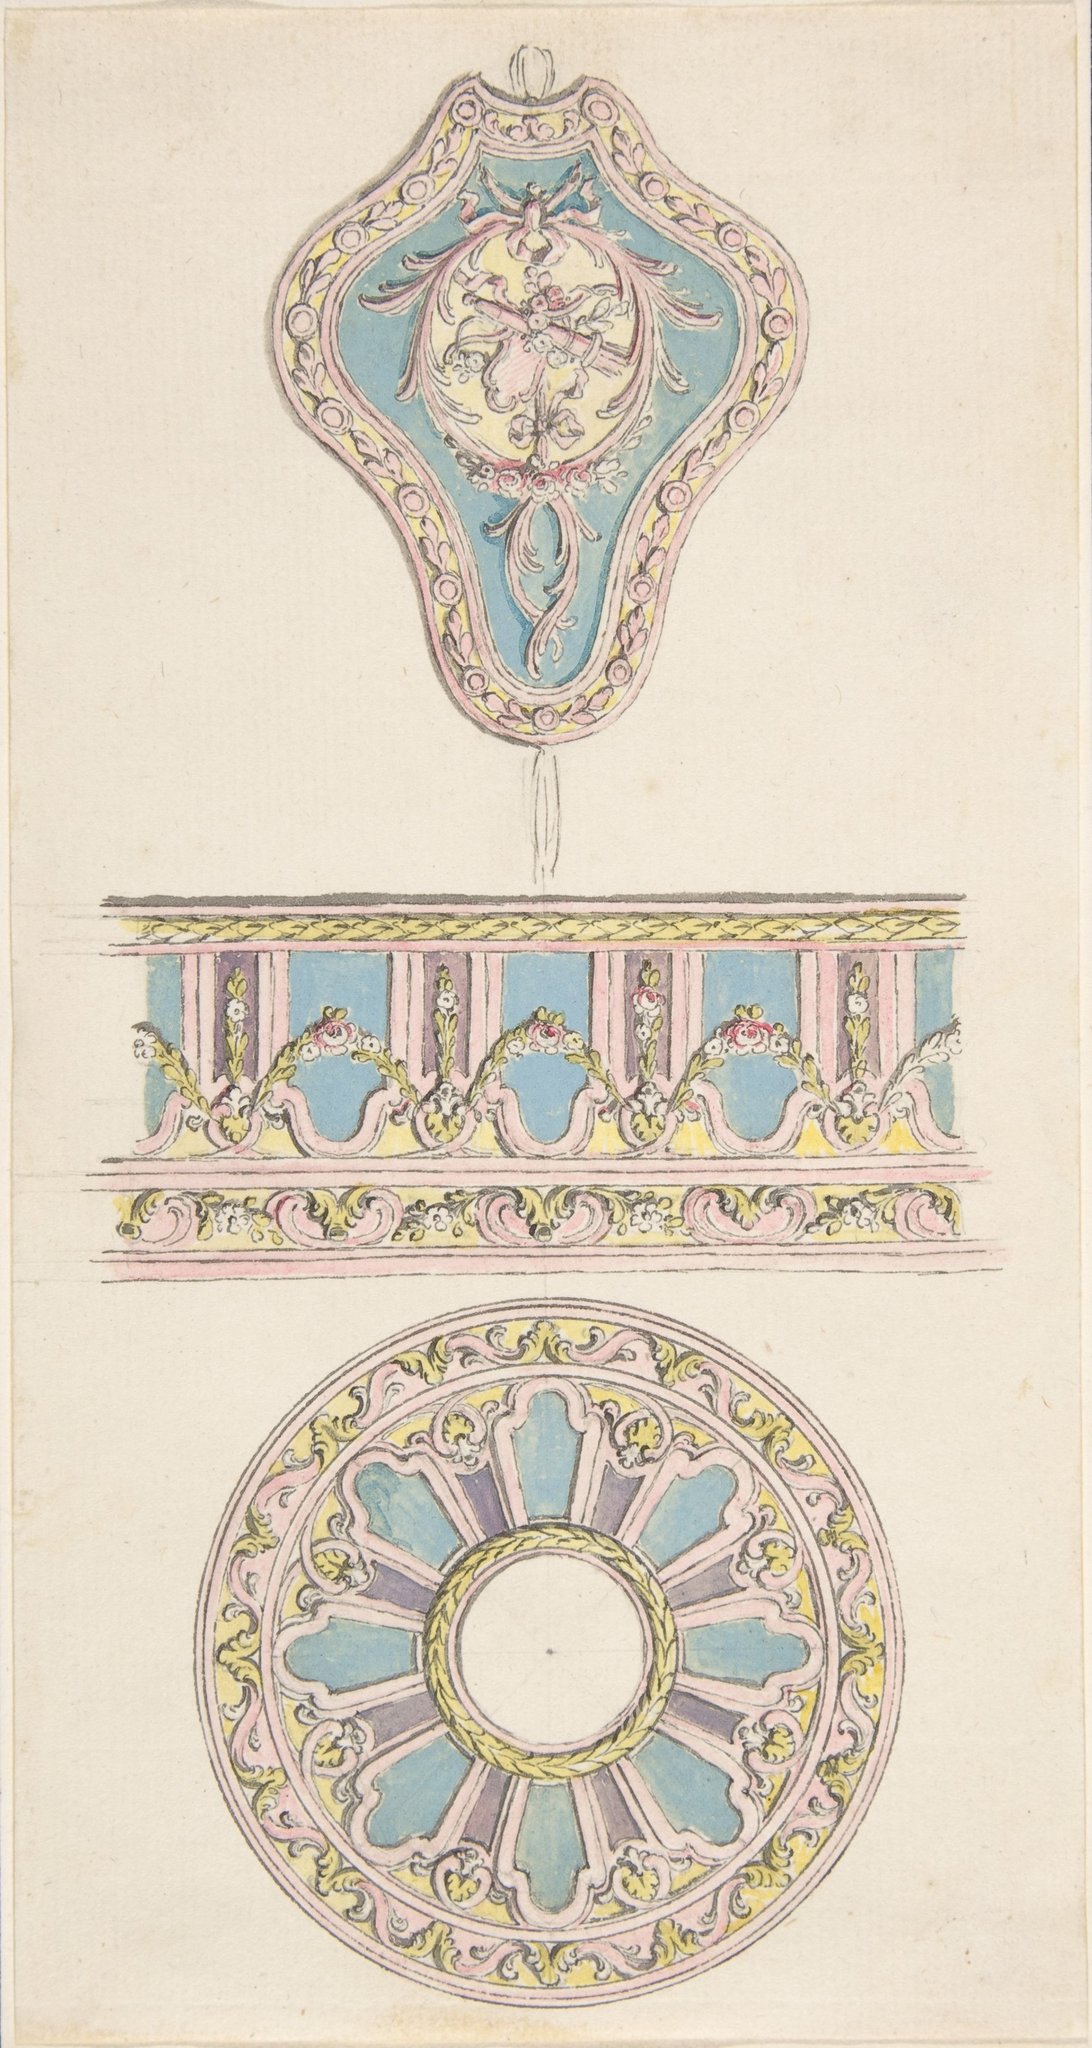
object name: drawing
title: Design for a Snuff Box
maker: pierre moreau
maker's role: artist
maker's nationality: french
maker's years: 1715-1798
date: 1750-1777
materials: ink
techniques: brush, pen, wash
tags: ornament